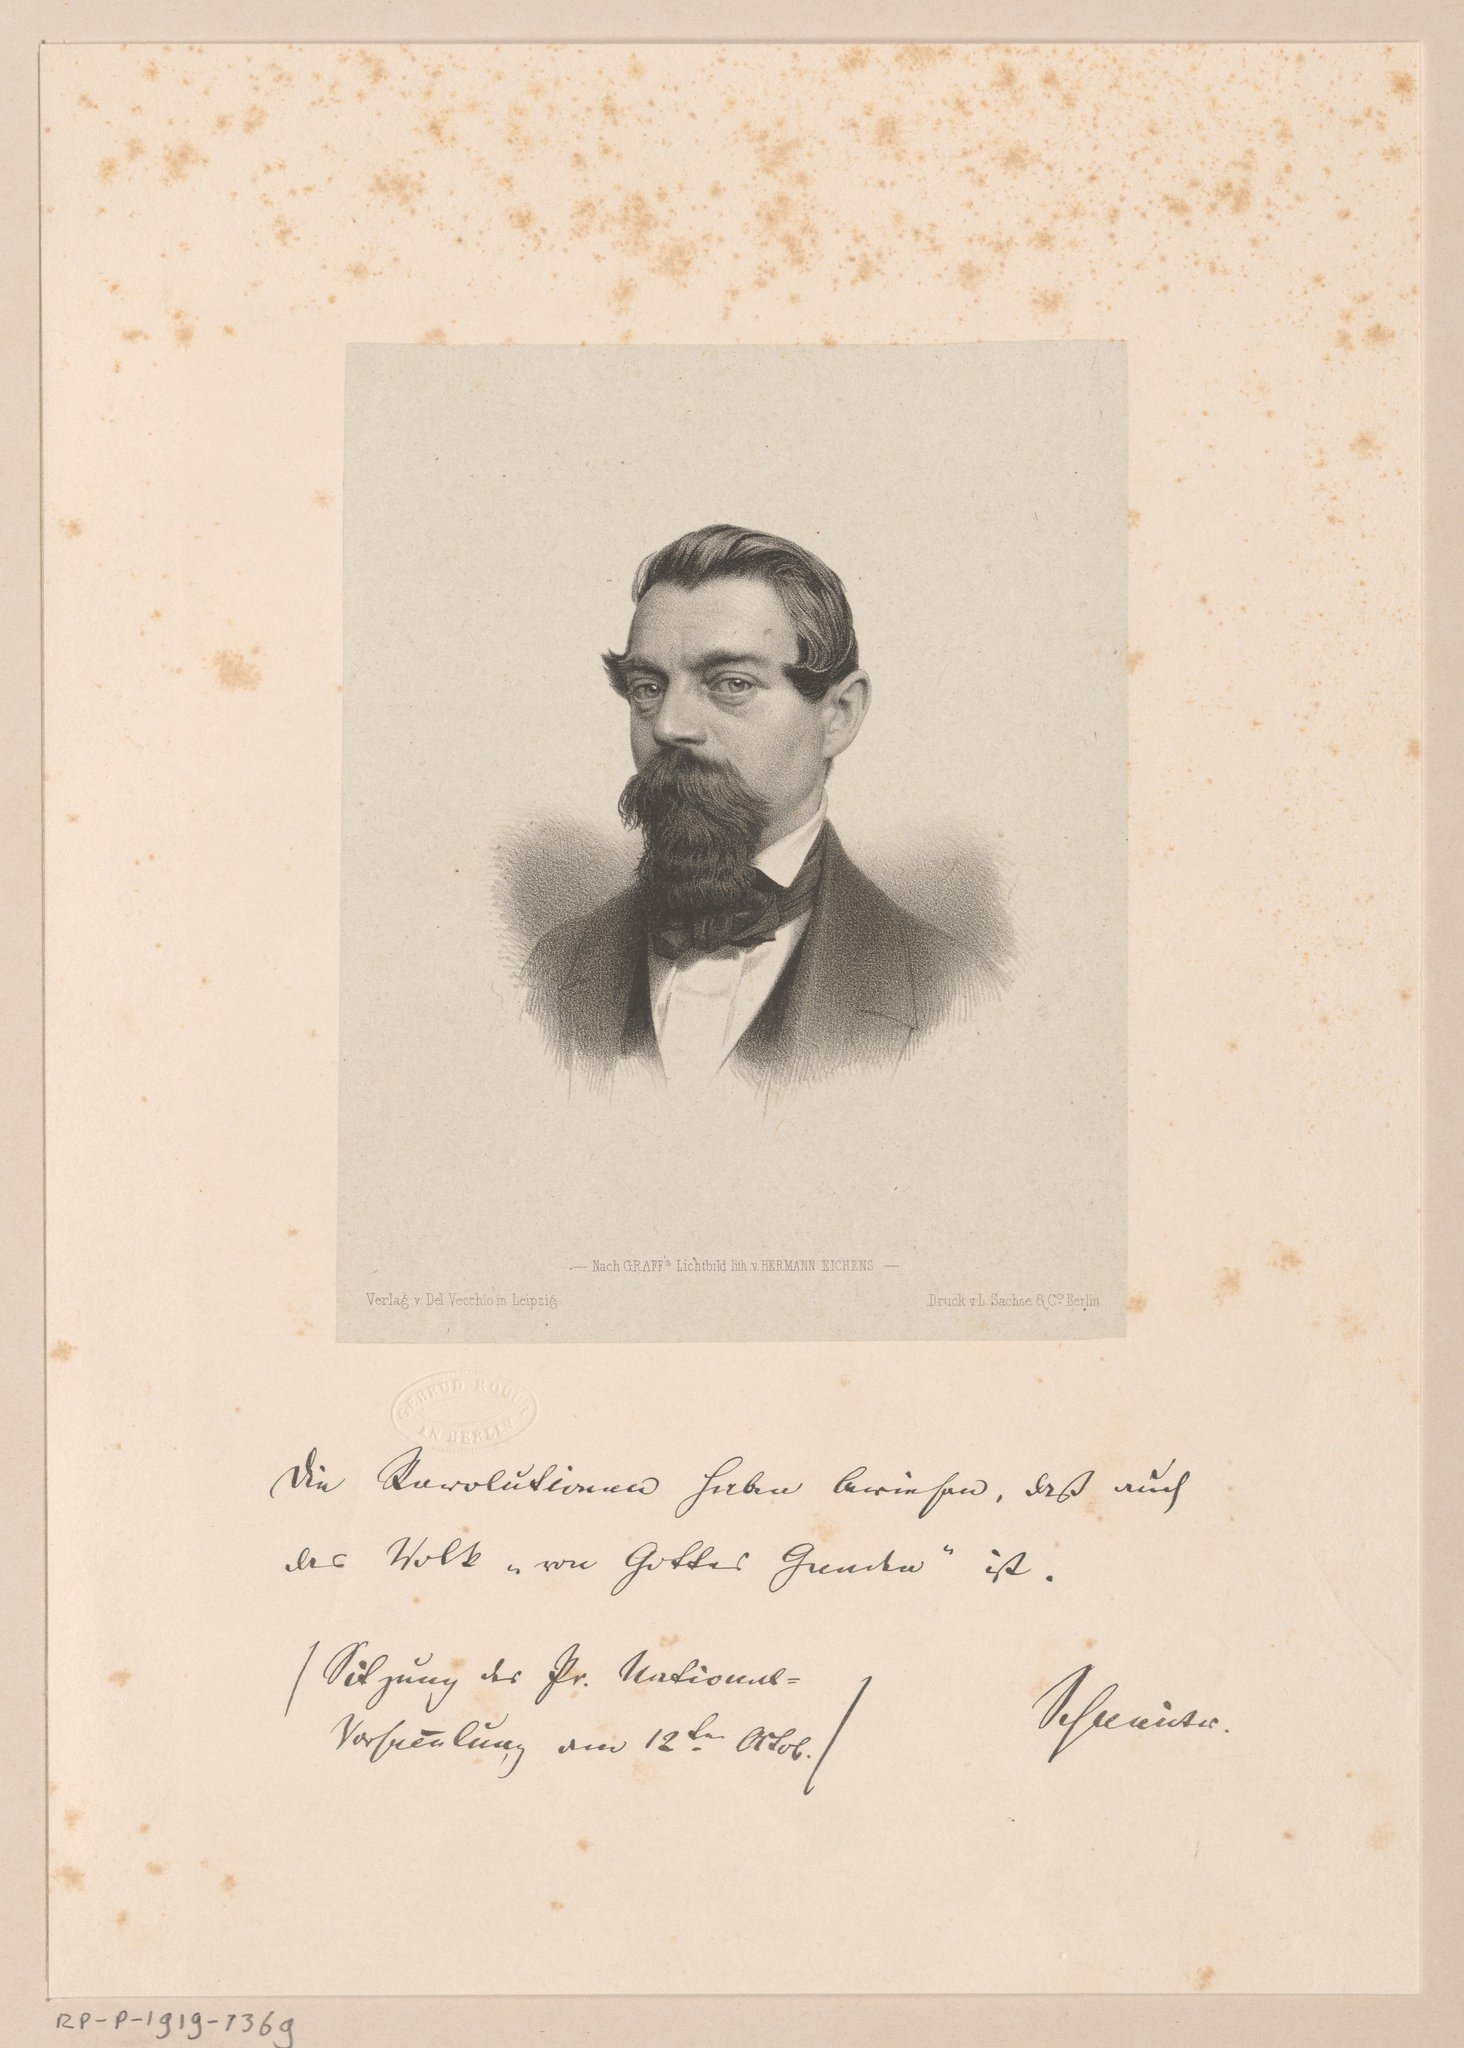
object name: print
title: Portret van Ludwig Karl Schneider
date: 1832-1854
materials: paper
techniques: lithograph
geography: leipzig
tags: historical persons, politician, e.g. party leader, botanizing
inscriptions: check stamp: Lugt 2141c, collector's mark: Lugt 2228